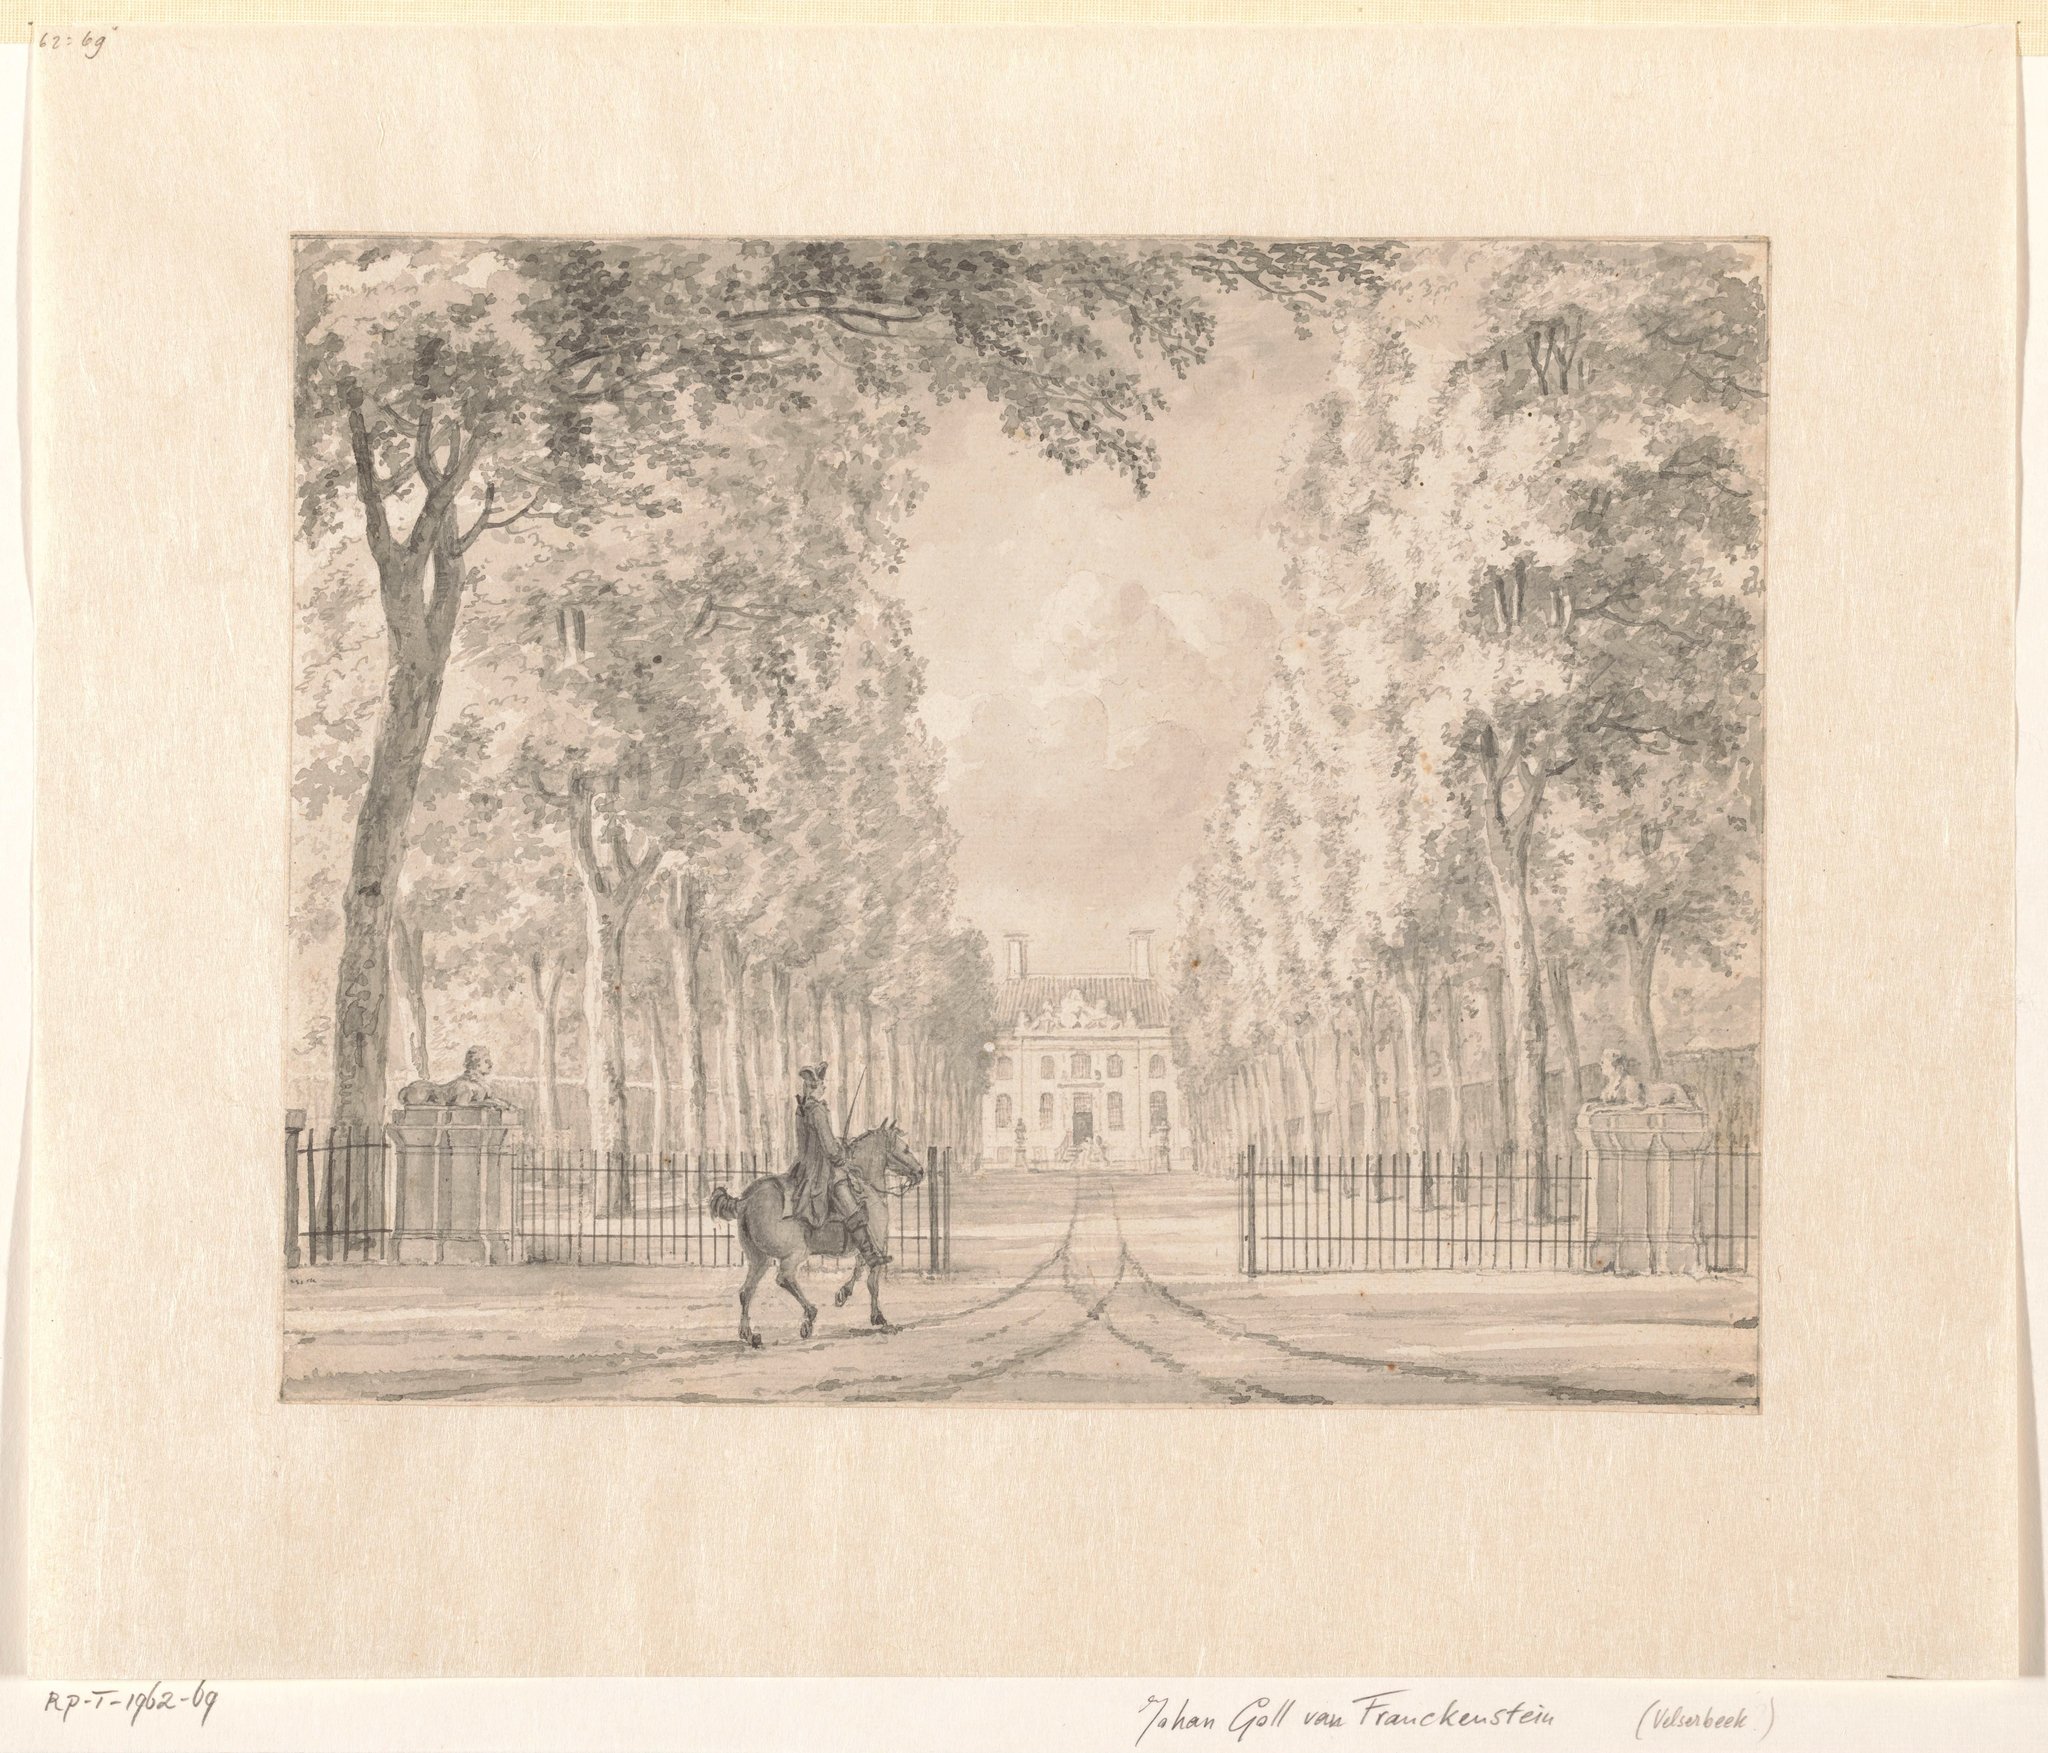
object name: drawing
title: Ruiter voor het hek van een buitenplaats (Velserbeek?)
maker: johann goll van frankenstein (i)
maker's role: amateurtekenaar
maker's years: 1722-1785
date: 1732-1785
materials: chalk, ink, paper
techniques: brush, pen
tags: castle